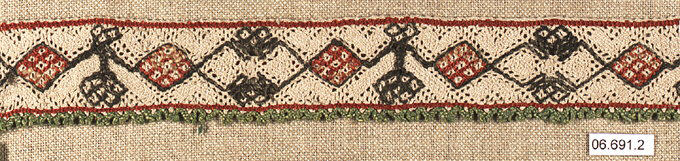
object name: strip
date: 1600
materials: silk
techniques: lace